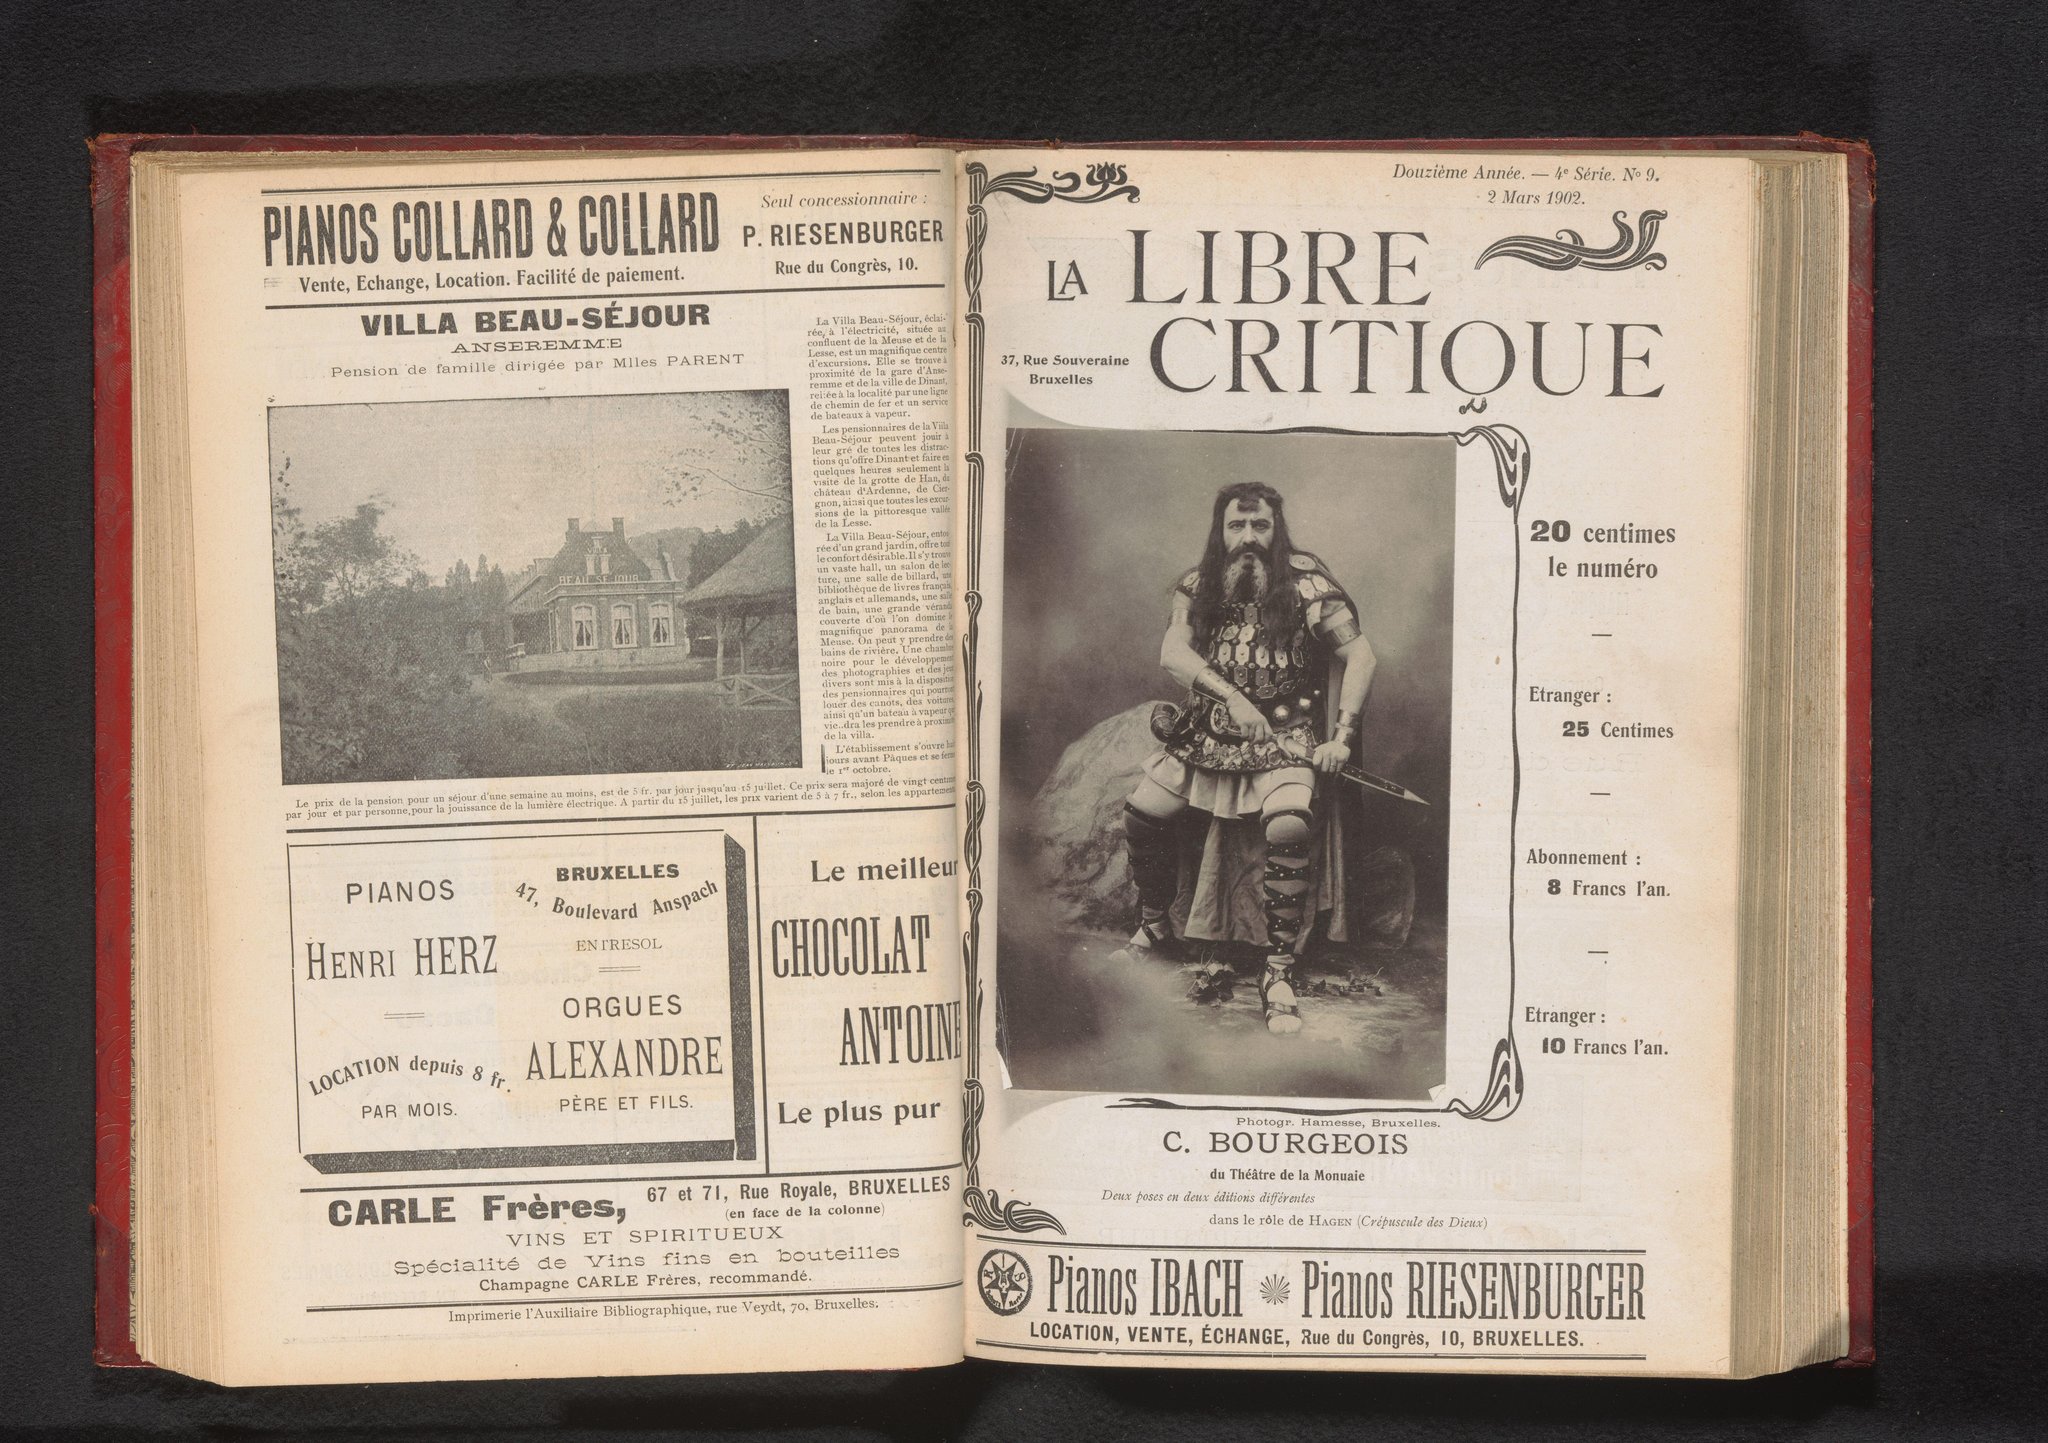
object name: photomechanical print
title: Portret van de heer Bourgeois als Hagen in Götterdämmerung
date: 1897-1902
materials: paper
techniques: photograph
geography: brussels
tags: opera-singer (male)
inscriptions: inscription: ‘du Théâtre (...) des Dieux)’